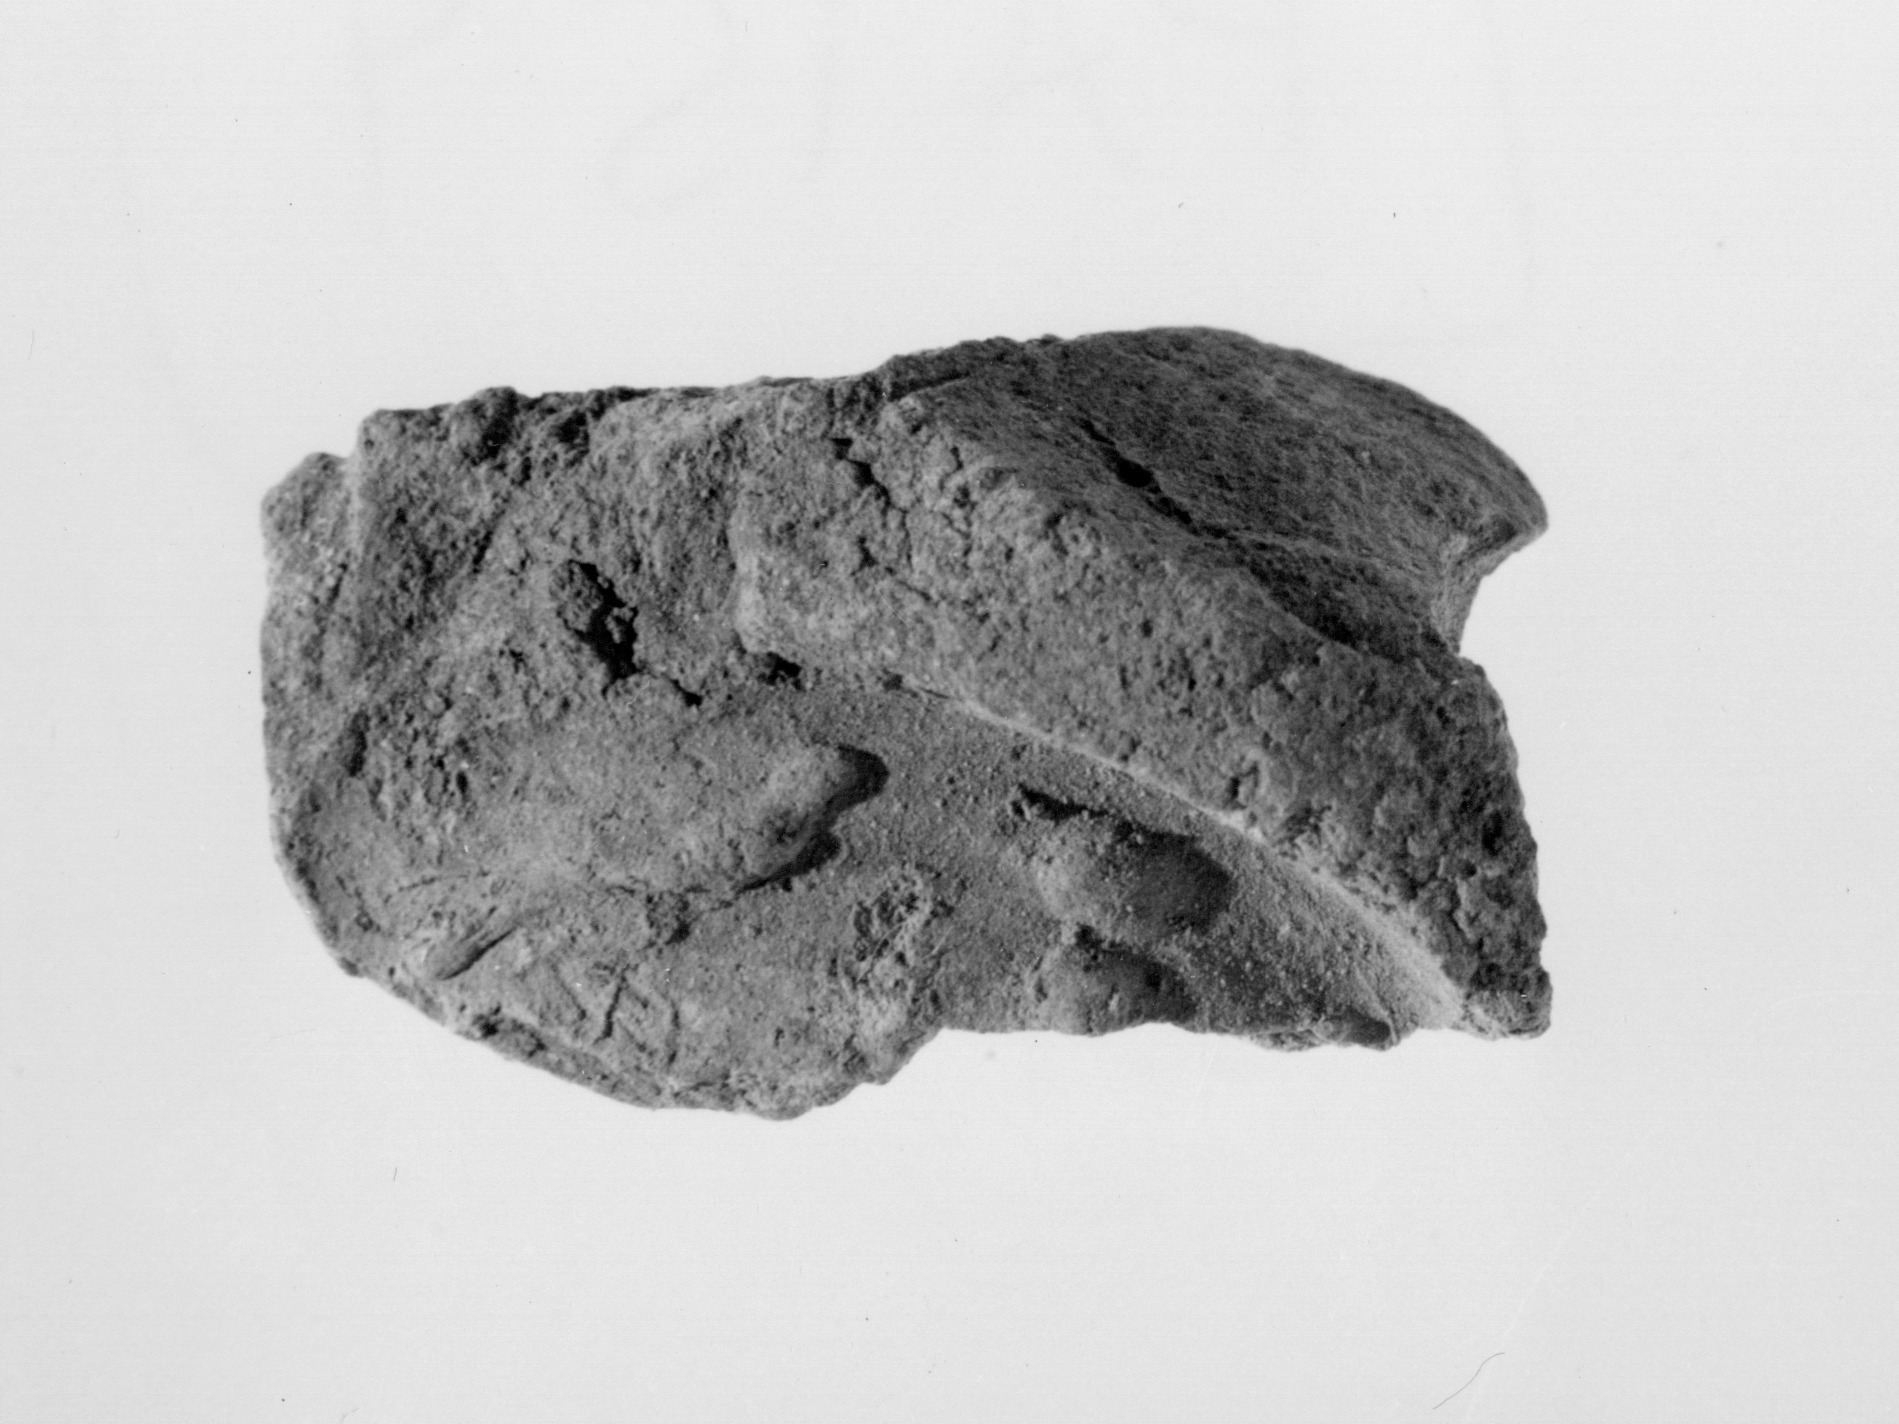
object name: sealing, amenhotep iii, nebmaatre, horus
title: Document Sealing With the Throne Name of Amenhotep III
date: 1390-1352 BCE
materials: mud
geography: egypt